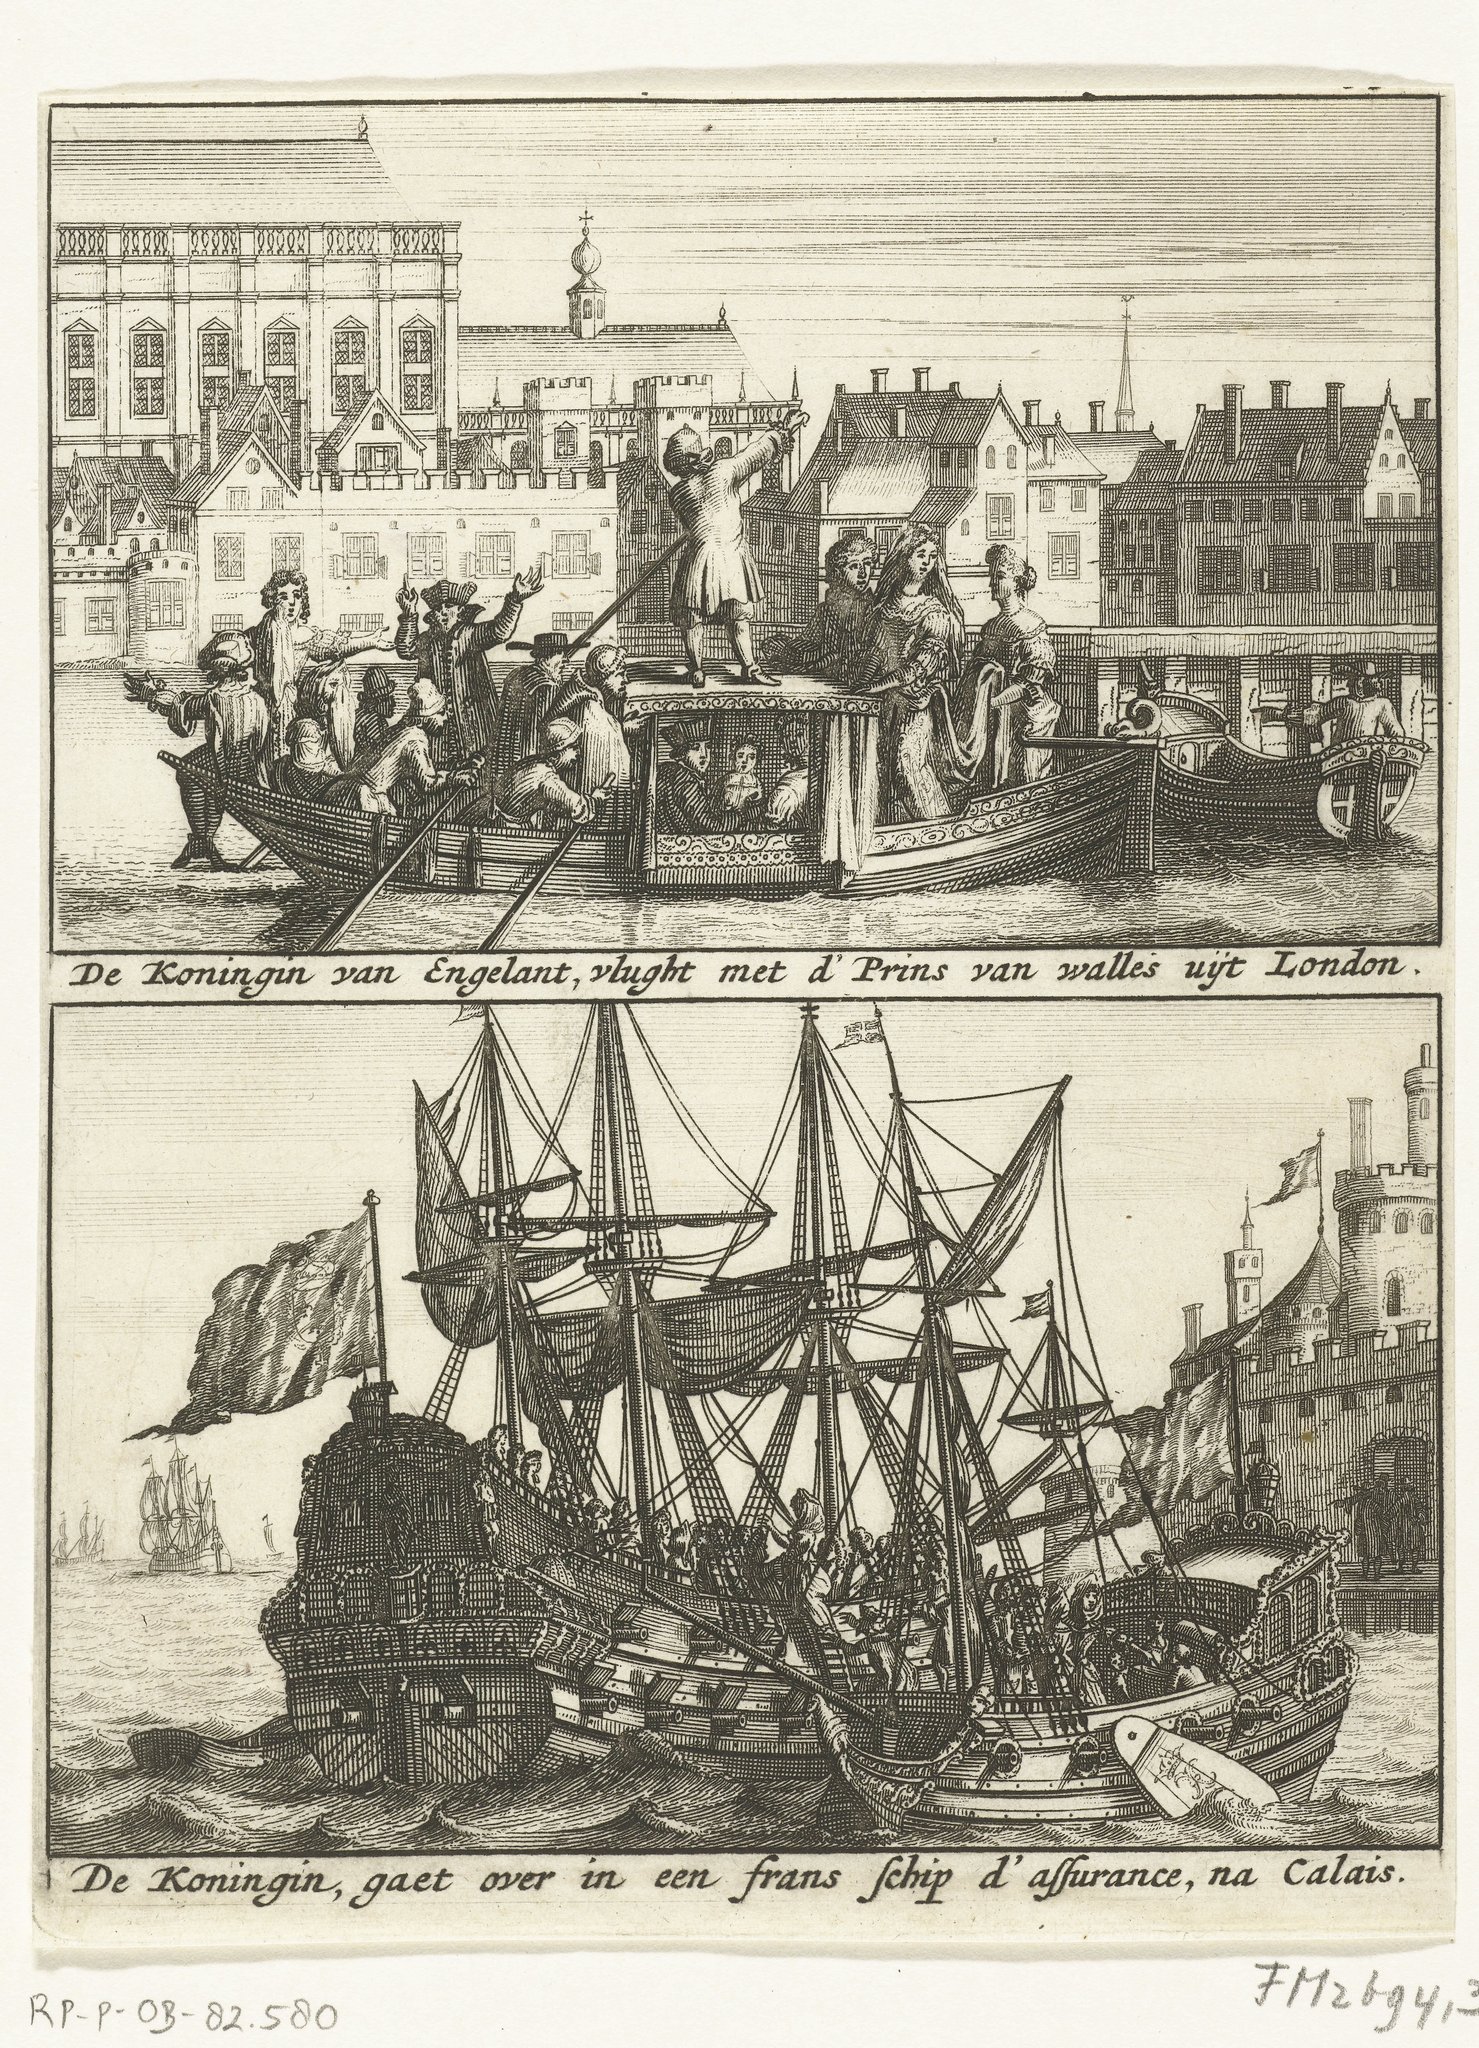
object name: print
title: De Koningin van Engelant, vlught met d'Prins van walles uyt London / De Koningin, gaet over in een frans schip d'assurance, na Calais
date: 1689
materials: paper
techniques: etching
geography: northern netherlands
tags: london, rome, flight of ruler from adversary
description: Blad met twee voorstellingen. Boven de vlucht van de koningin Maria met de prins van Wales uit Londen, 19 december 1688. Onder gaat de koningin aan boord van een Frans schip naar Calais.